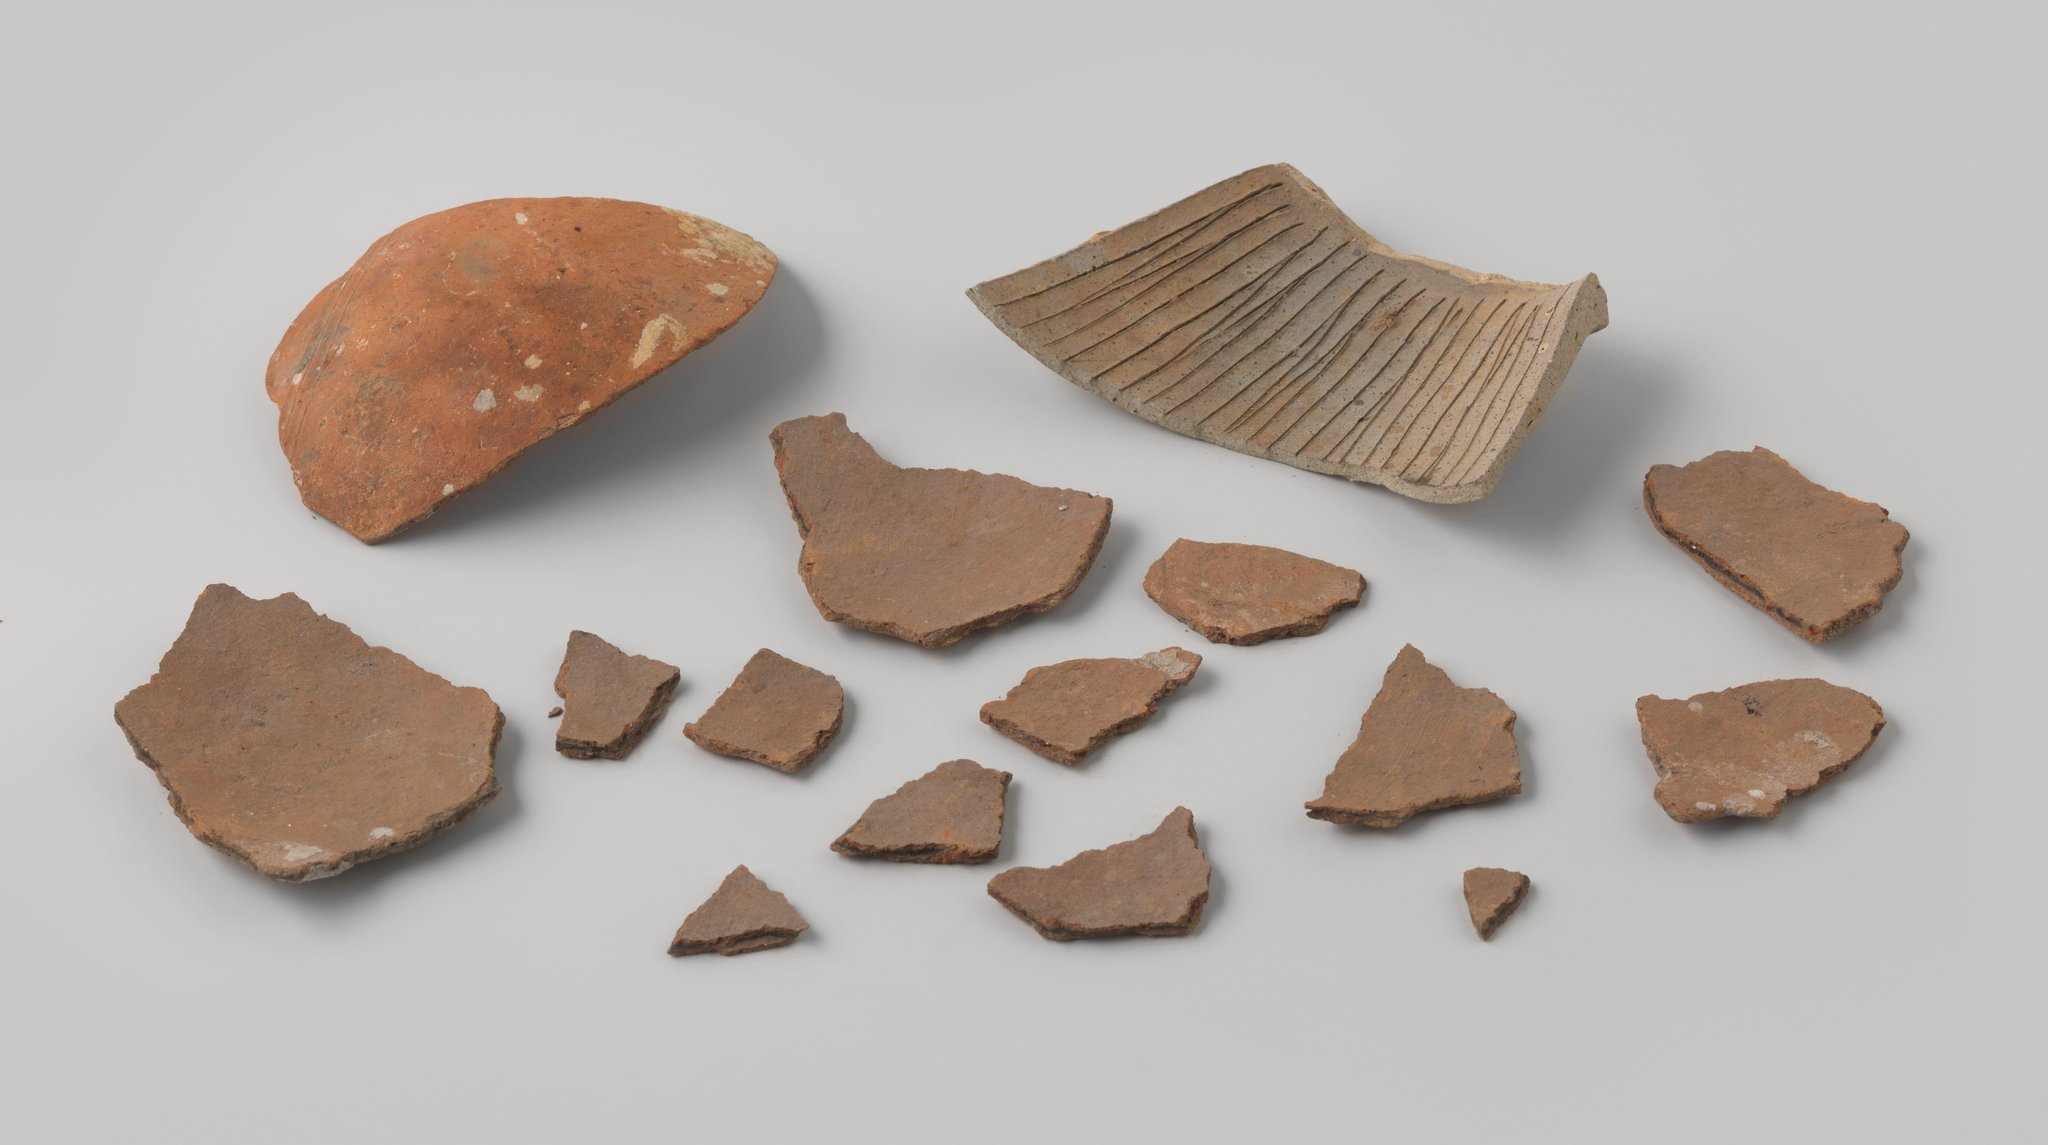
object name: sherd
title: Zak met scherven aardewerk en steengoed uit V.O.C.-schip de 'Witte Leeuw'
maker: Anonymous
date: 1613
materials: earthenware, stoneware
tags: verenigde oostindische compagnie, sint-helena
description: Zak met scherven aardewerk en steengoed uit V.O.C.-schip de 'Witte Leeuw'. Steengoedscherf met verticale krassen aan de binnenzijde.